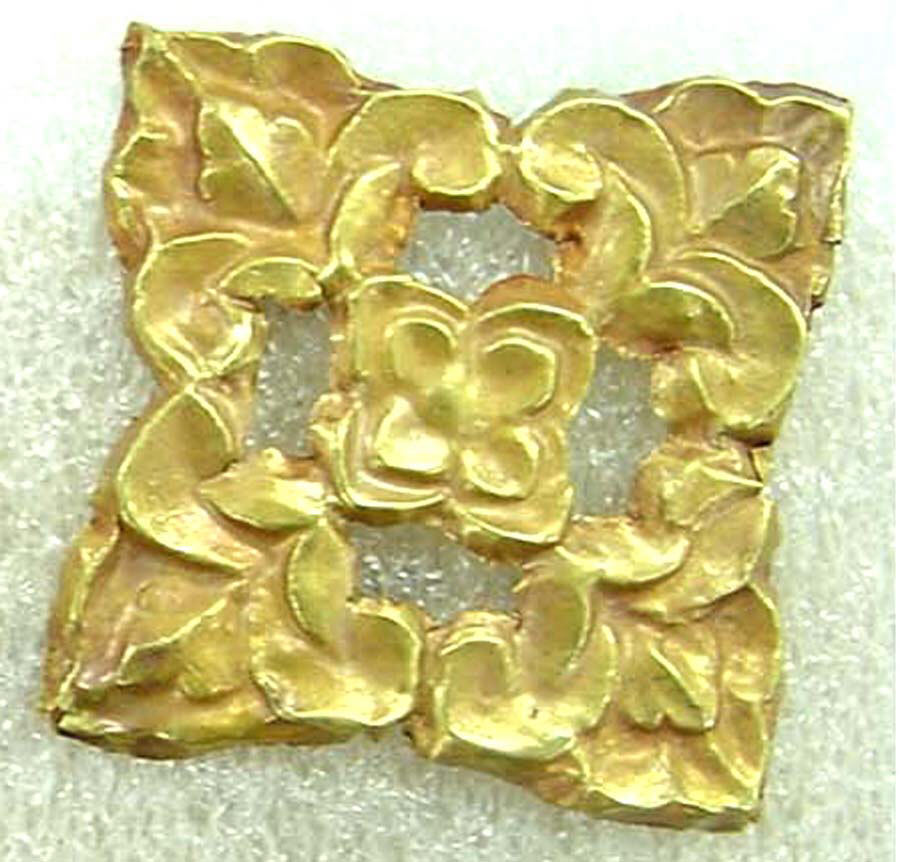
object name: plaque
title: Square Plaque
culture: northwest chinese or eastern central asian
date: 634-900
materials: gold